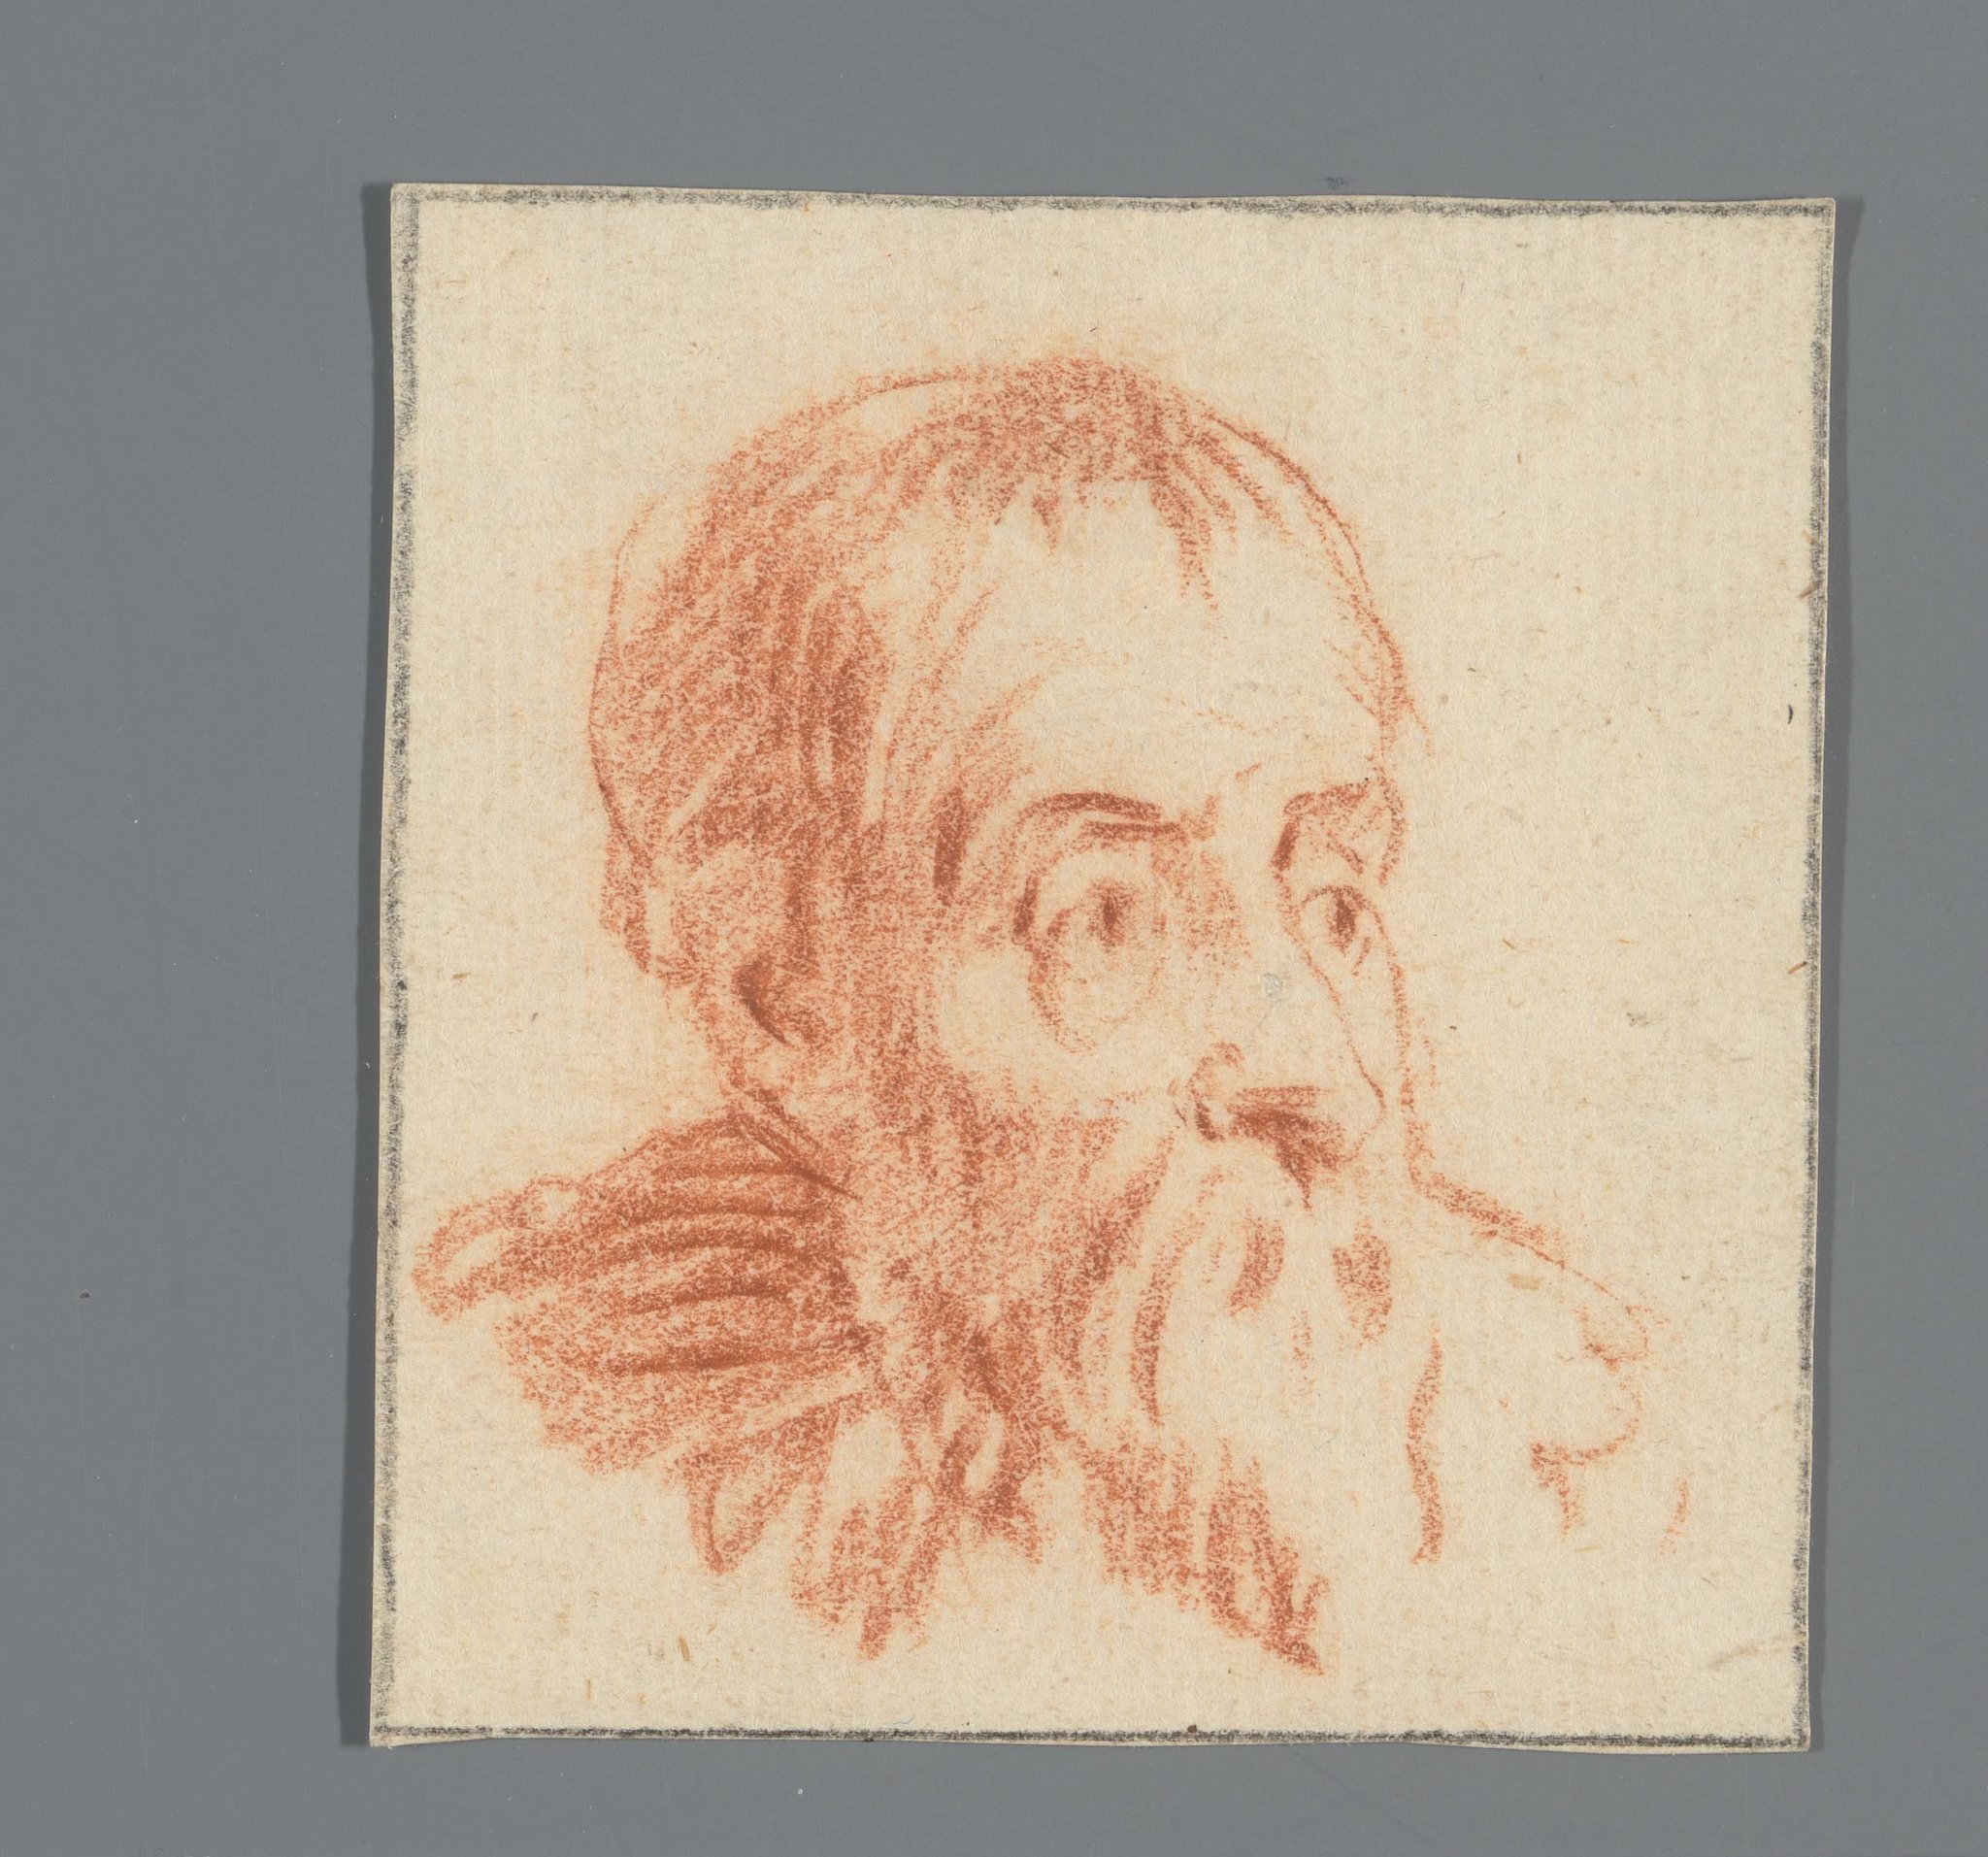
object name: drawing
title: Manshoofd, met baard, driekwart naar rechts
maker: Anonymous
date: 1700-1800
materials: chalk, paper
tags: anonymous historical person portrayed alone